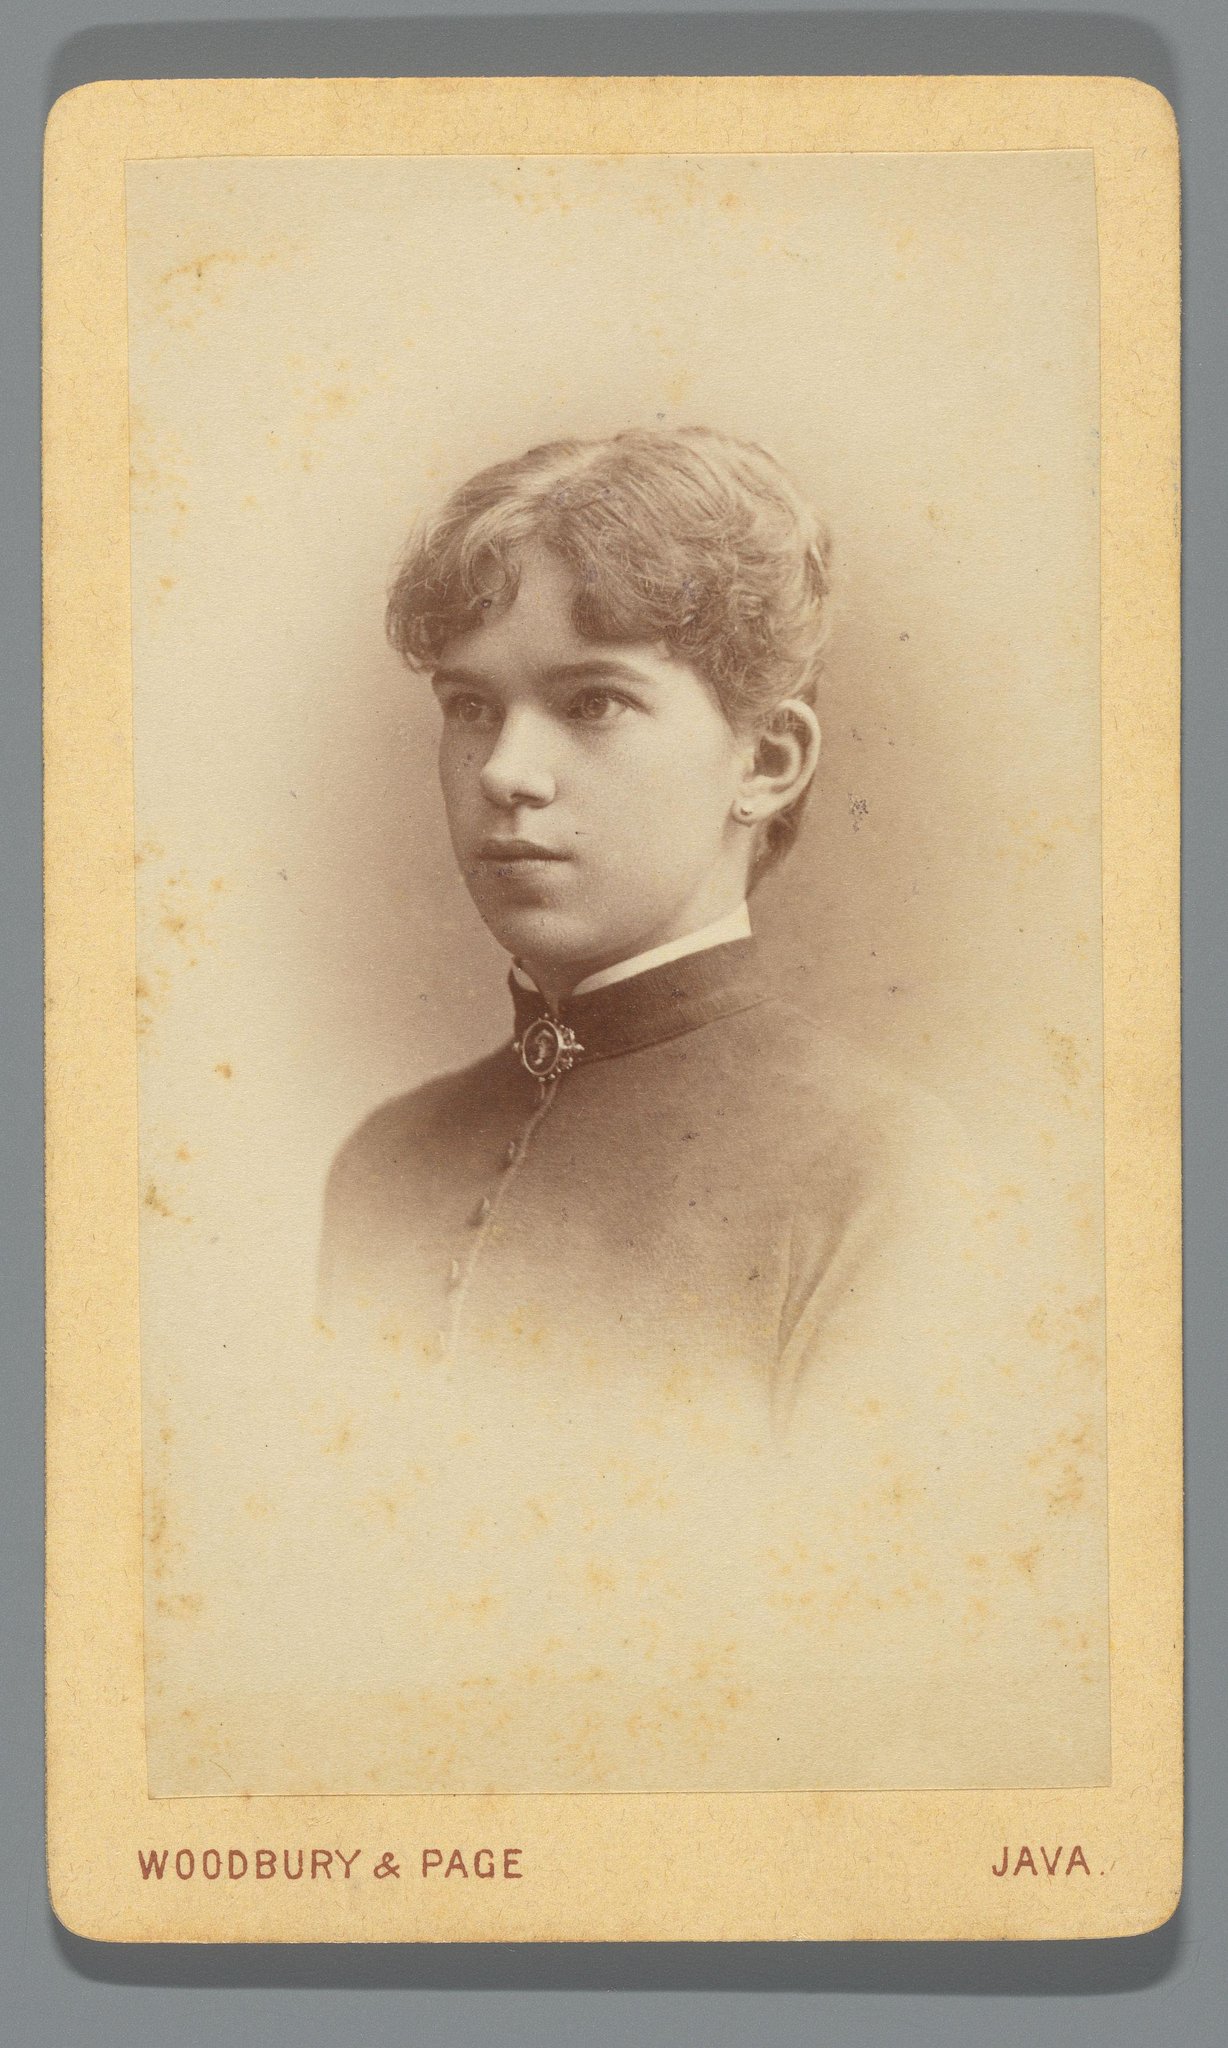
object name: photograph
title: Portret van Emilie Onnen-van den Berg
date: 1880-1900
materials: cardboard, photographic support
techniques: albumen print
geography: java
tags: batavia, emilie albertine onnen-van den berg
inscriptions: inscription: ‘Emilie Onnen- / van den Berg’, name: ‘WOODBURY & PAGE JAVA.’, name: ‘WOODBURY & PAGE / PHOTOGRAPHERS / JAVA.’